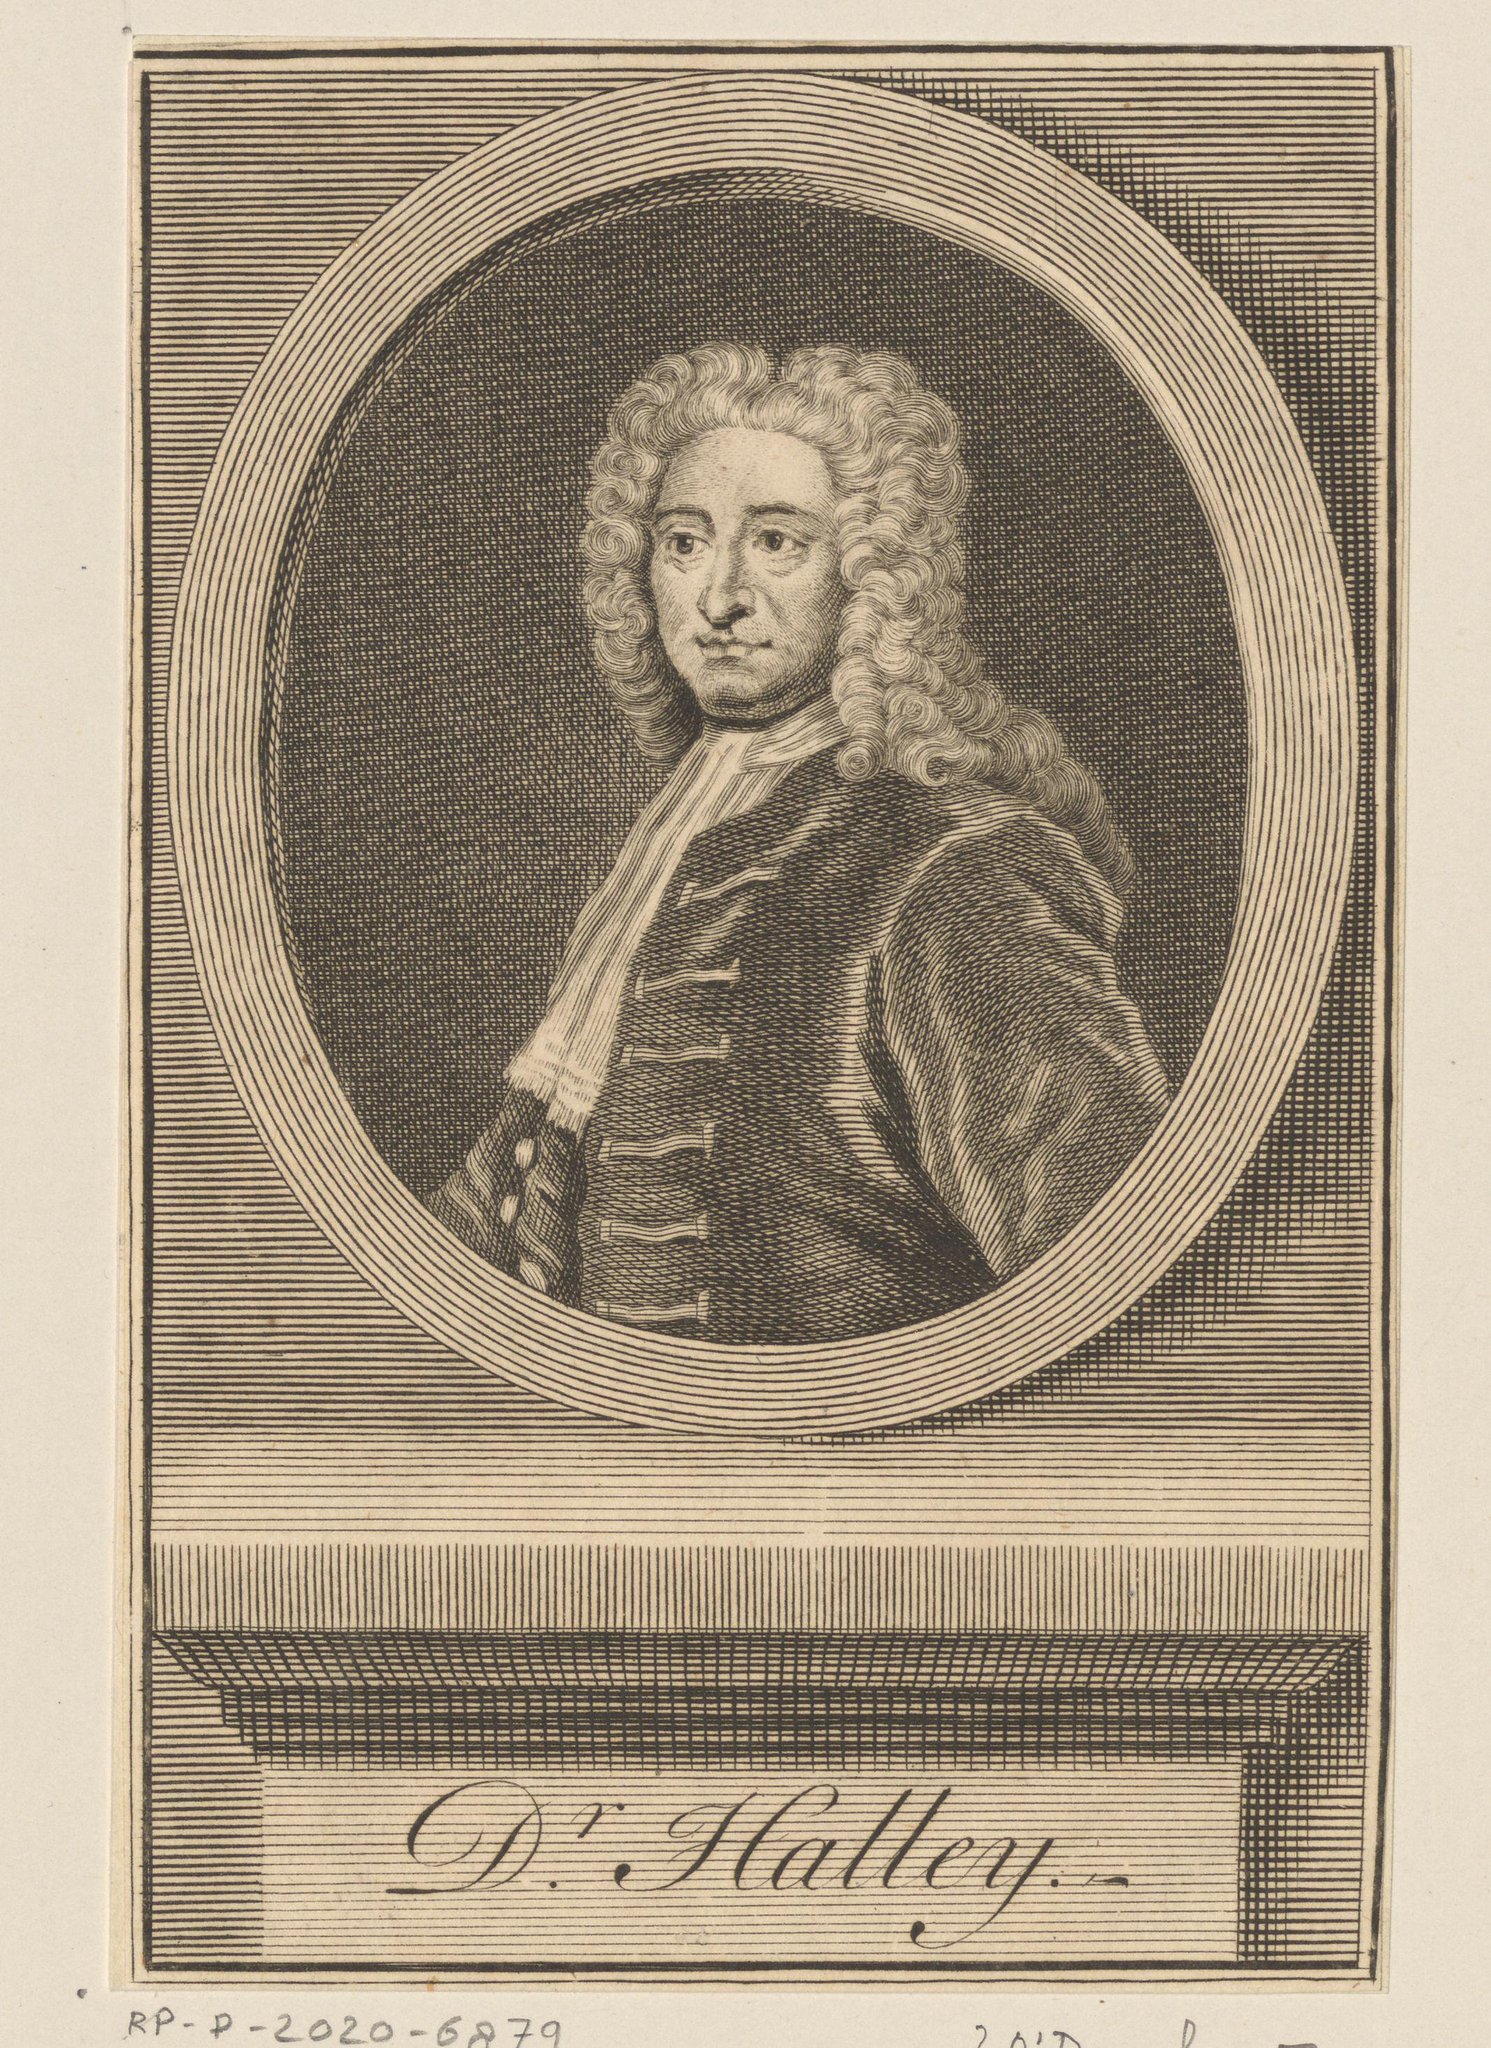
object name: print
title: Portret van Edmond Halley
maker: Anonymous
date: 1750-1799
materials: paper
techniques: engraving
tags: edmond halley, scholar, philosopher, historical persons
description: Prent mogelijk uit: The Universal Magazine of Knowledge and Pleasure, 1747-1781.